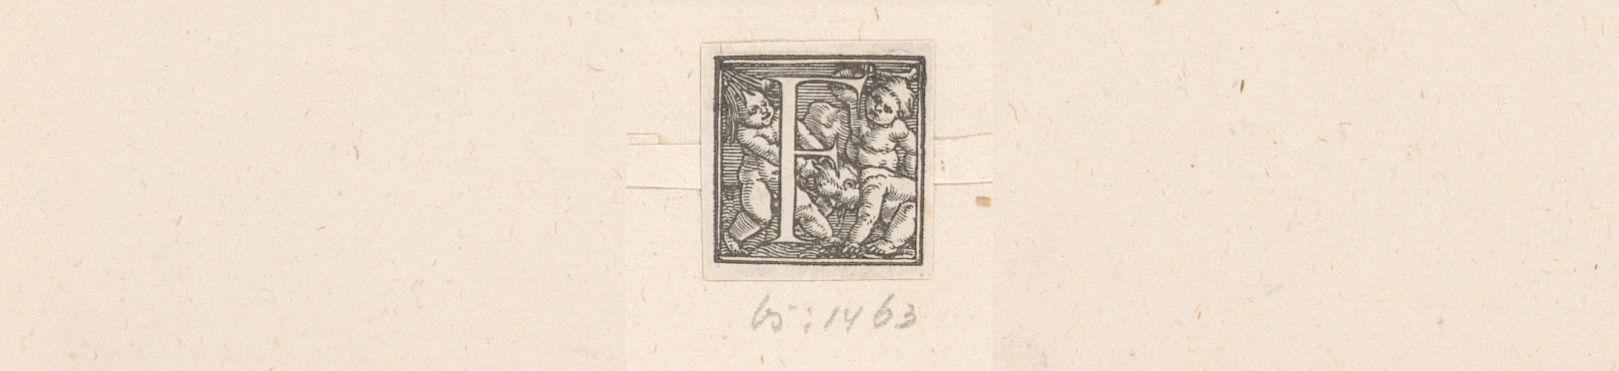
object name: book illustration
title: Initiaal F met een kind dat aan de haren wordt getrokken terwijl een ander het kind slaat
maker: hans lützelburger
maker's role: print maker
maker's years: -1526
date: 1522-1526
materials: paper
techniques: woodcut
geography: basel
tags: initial, cupids: 'amores', 'amoretti', 'putti'